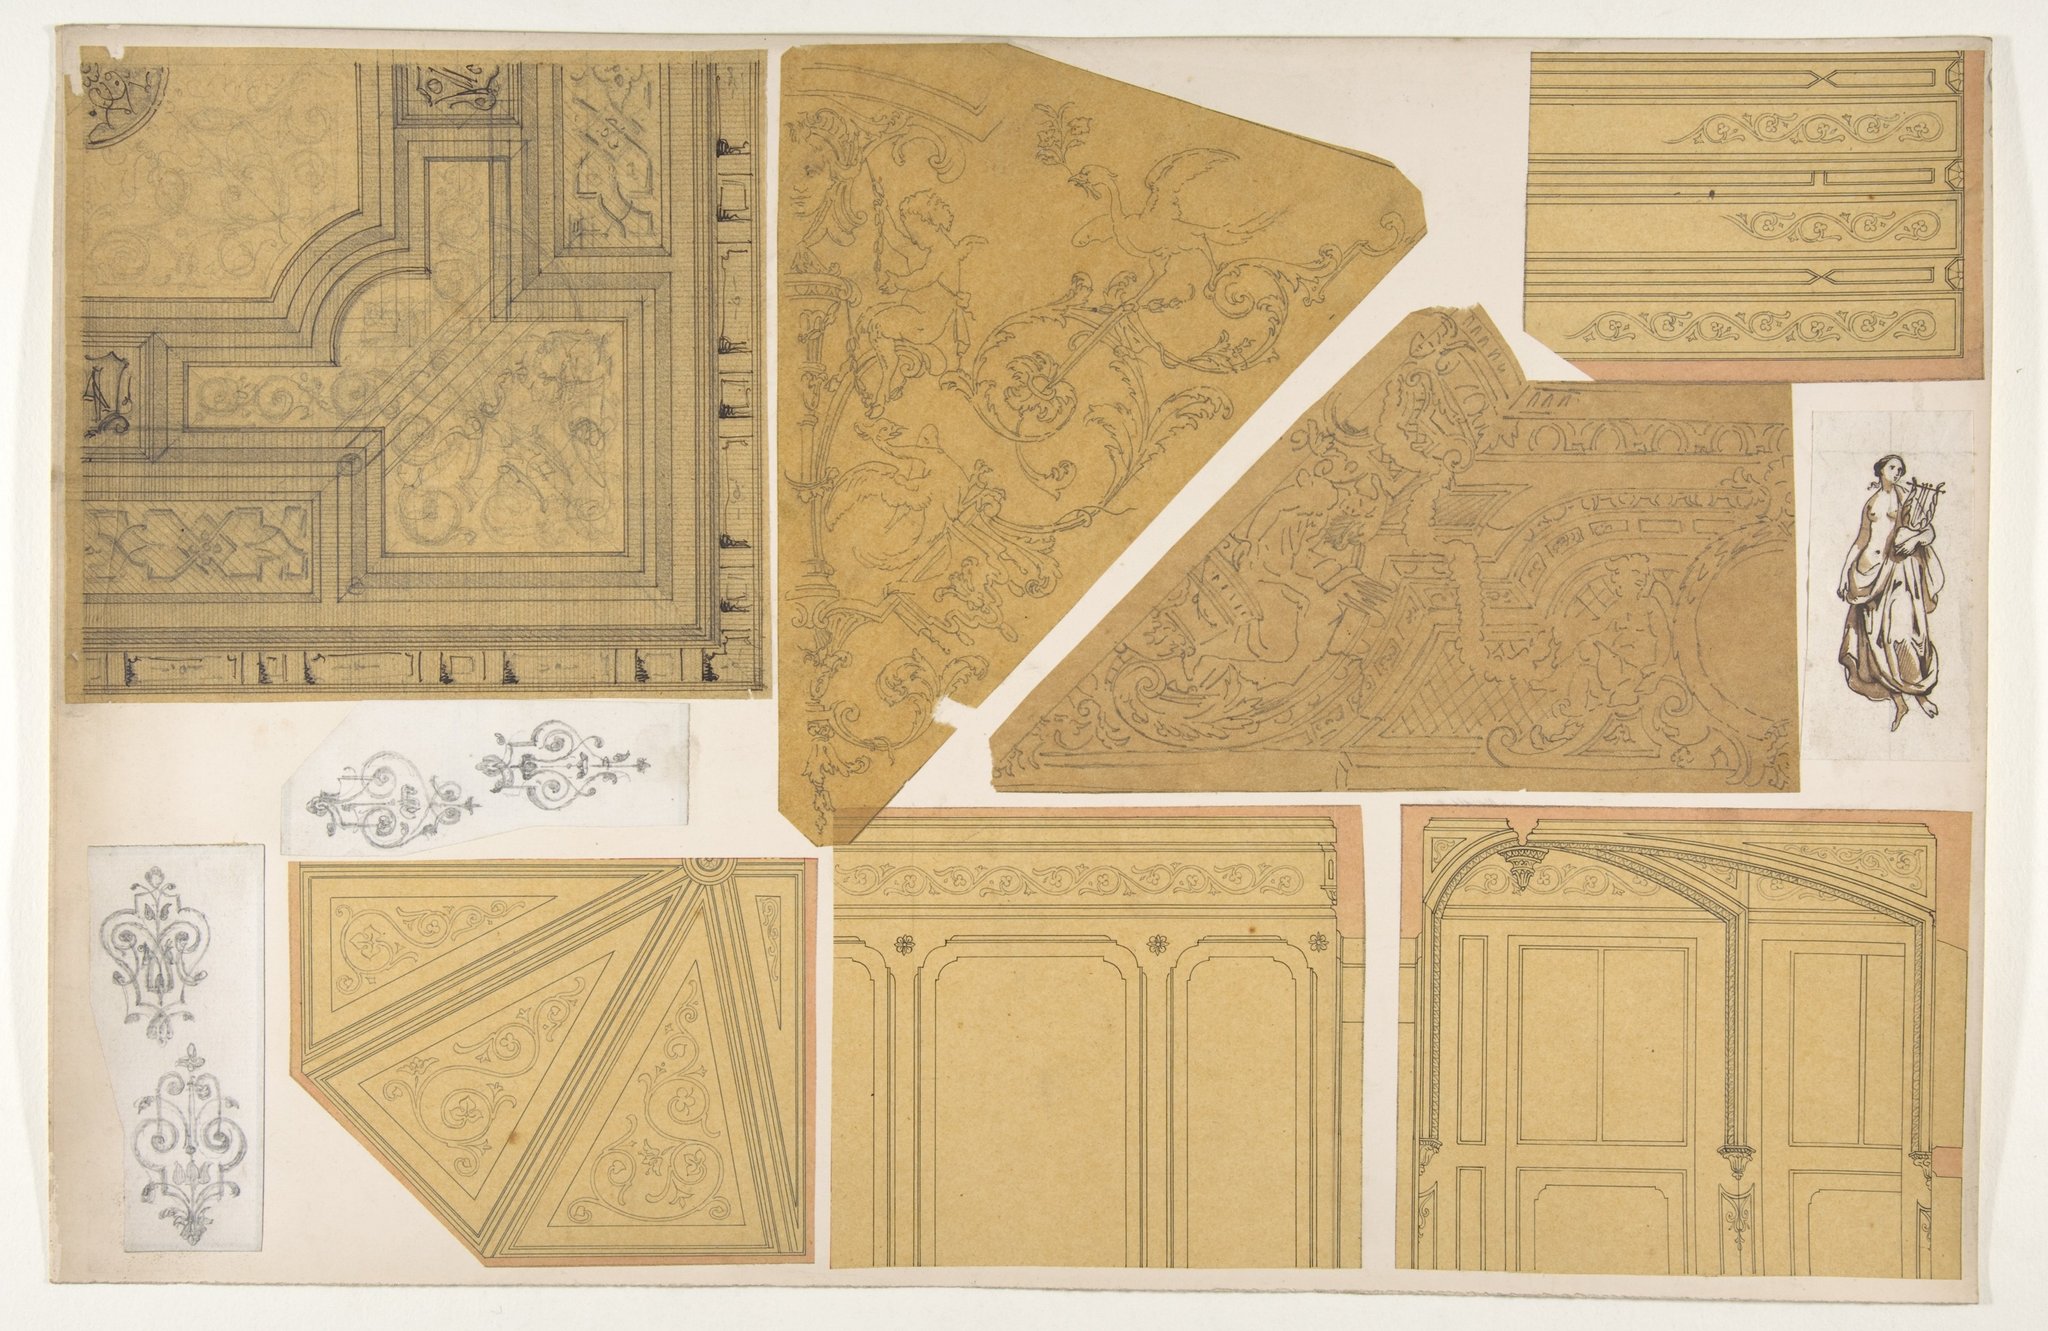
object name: drawing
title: Ten designs for the decoration of interiors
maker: jules-edmond-charles lachaise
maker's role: artist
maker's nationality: french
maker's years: 1897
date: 1830-1897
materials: cardboard, graphite, ink, paper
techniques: pen, wash